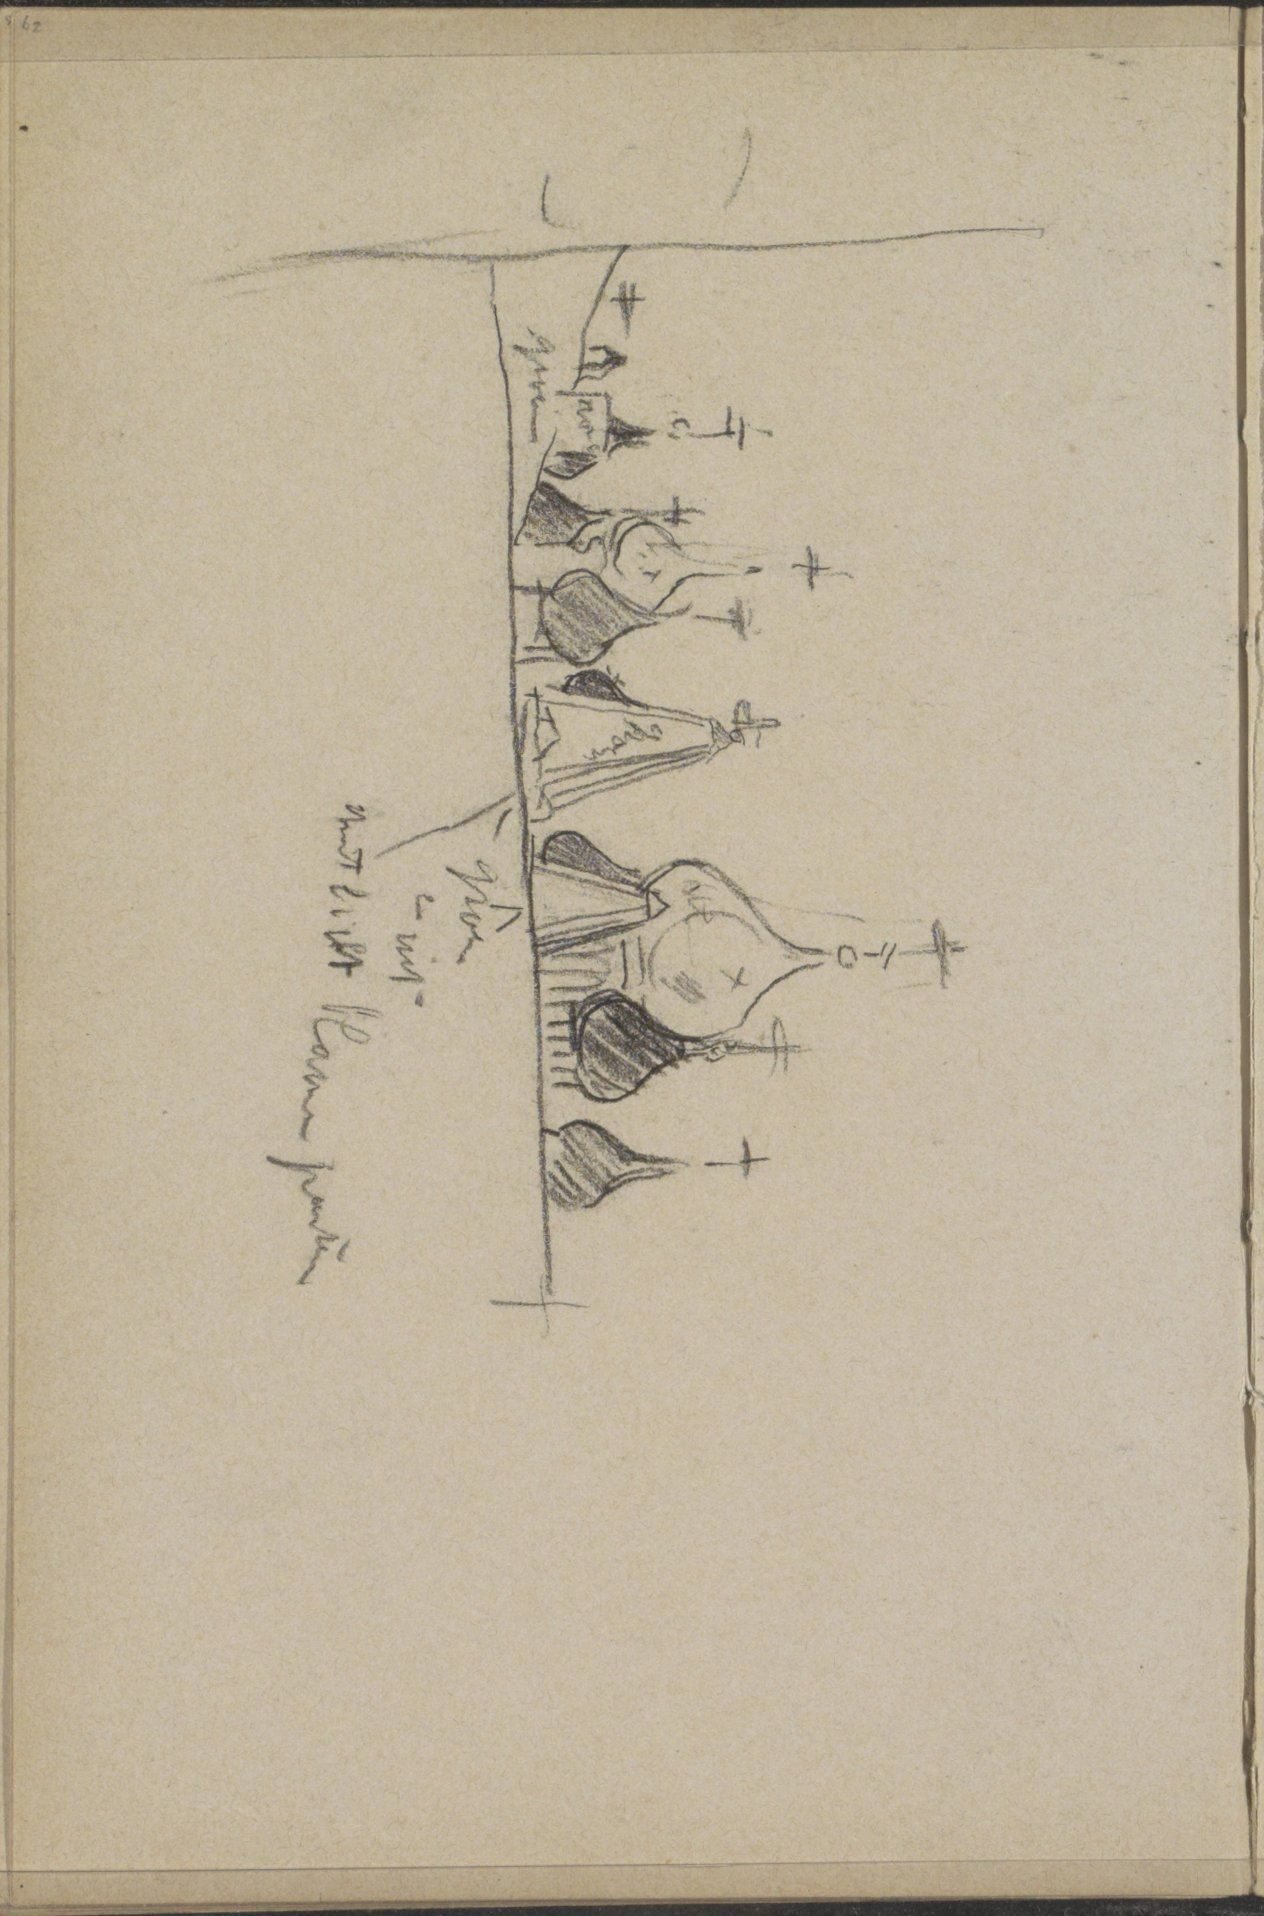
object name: sketchbook leaf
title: Koepels van het Kremlin van Moskou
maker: marius bauer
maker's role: draughtsman, print maker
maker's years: 1867-1932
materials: chalk, paper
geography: moscow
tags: spire (of tower on house or building), dome ~ architecture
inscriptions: kleurnotitie, handgeschreven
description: Pagina 62 uit een schetsboek met 54 bladen.